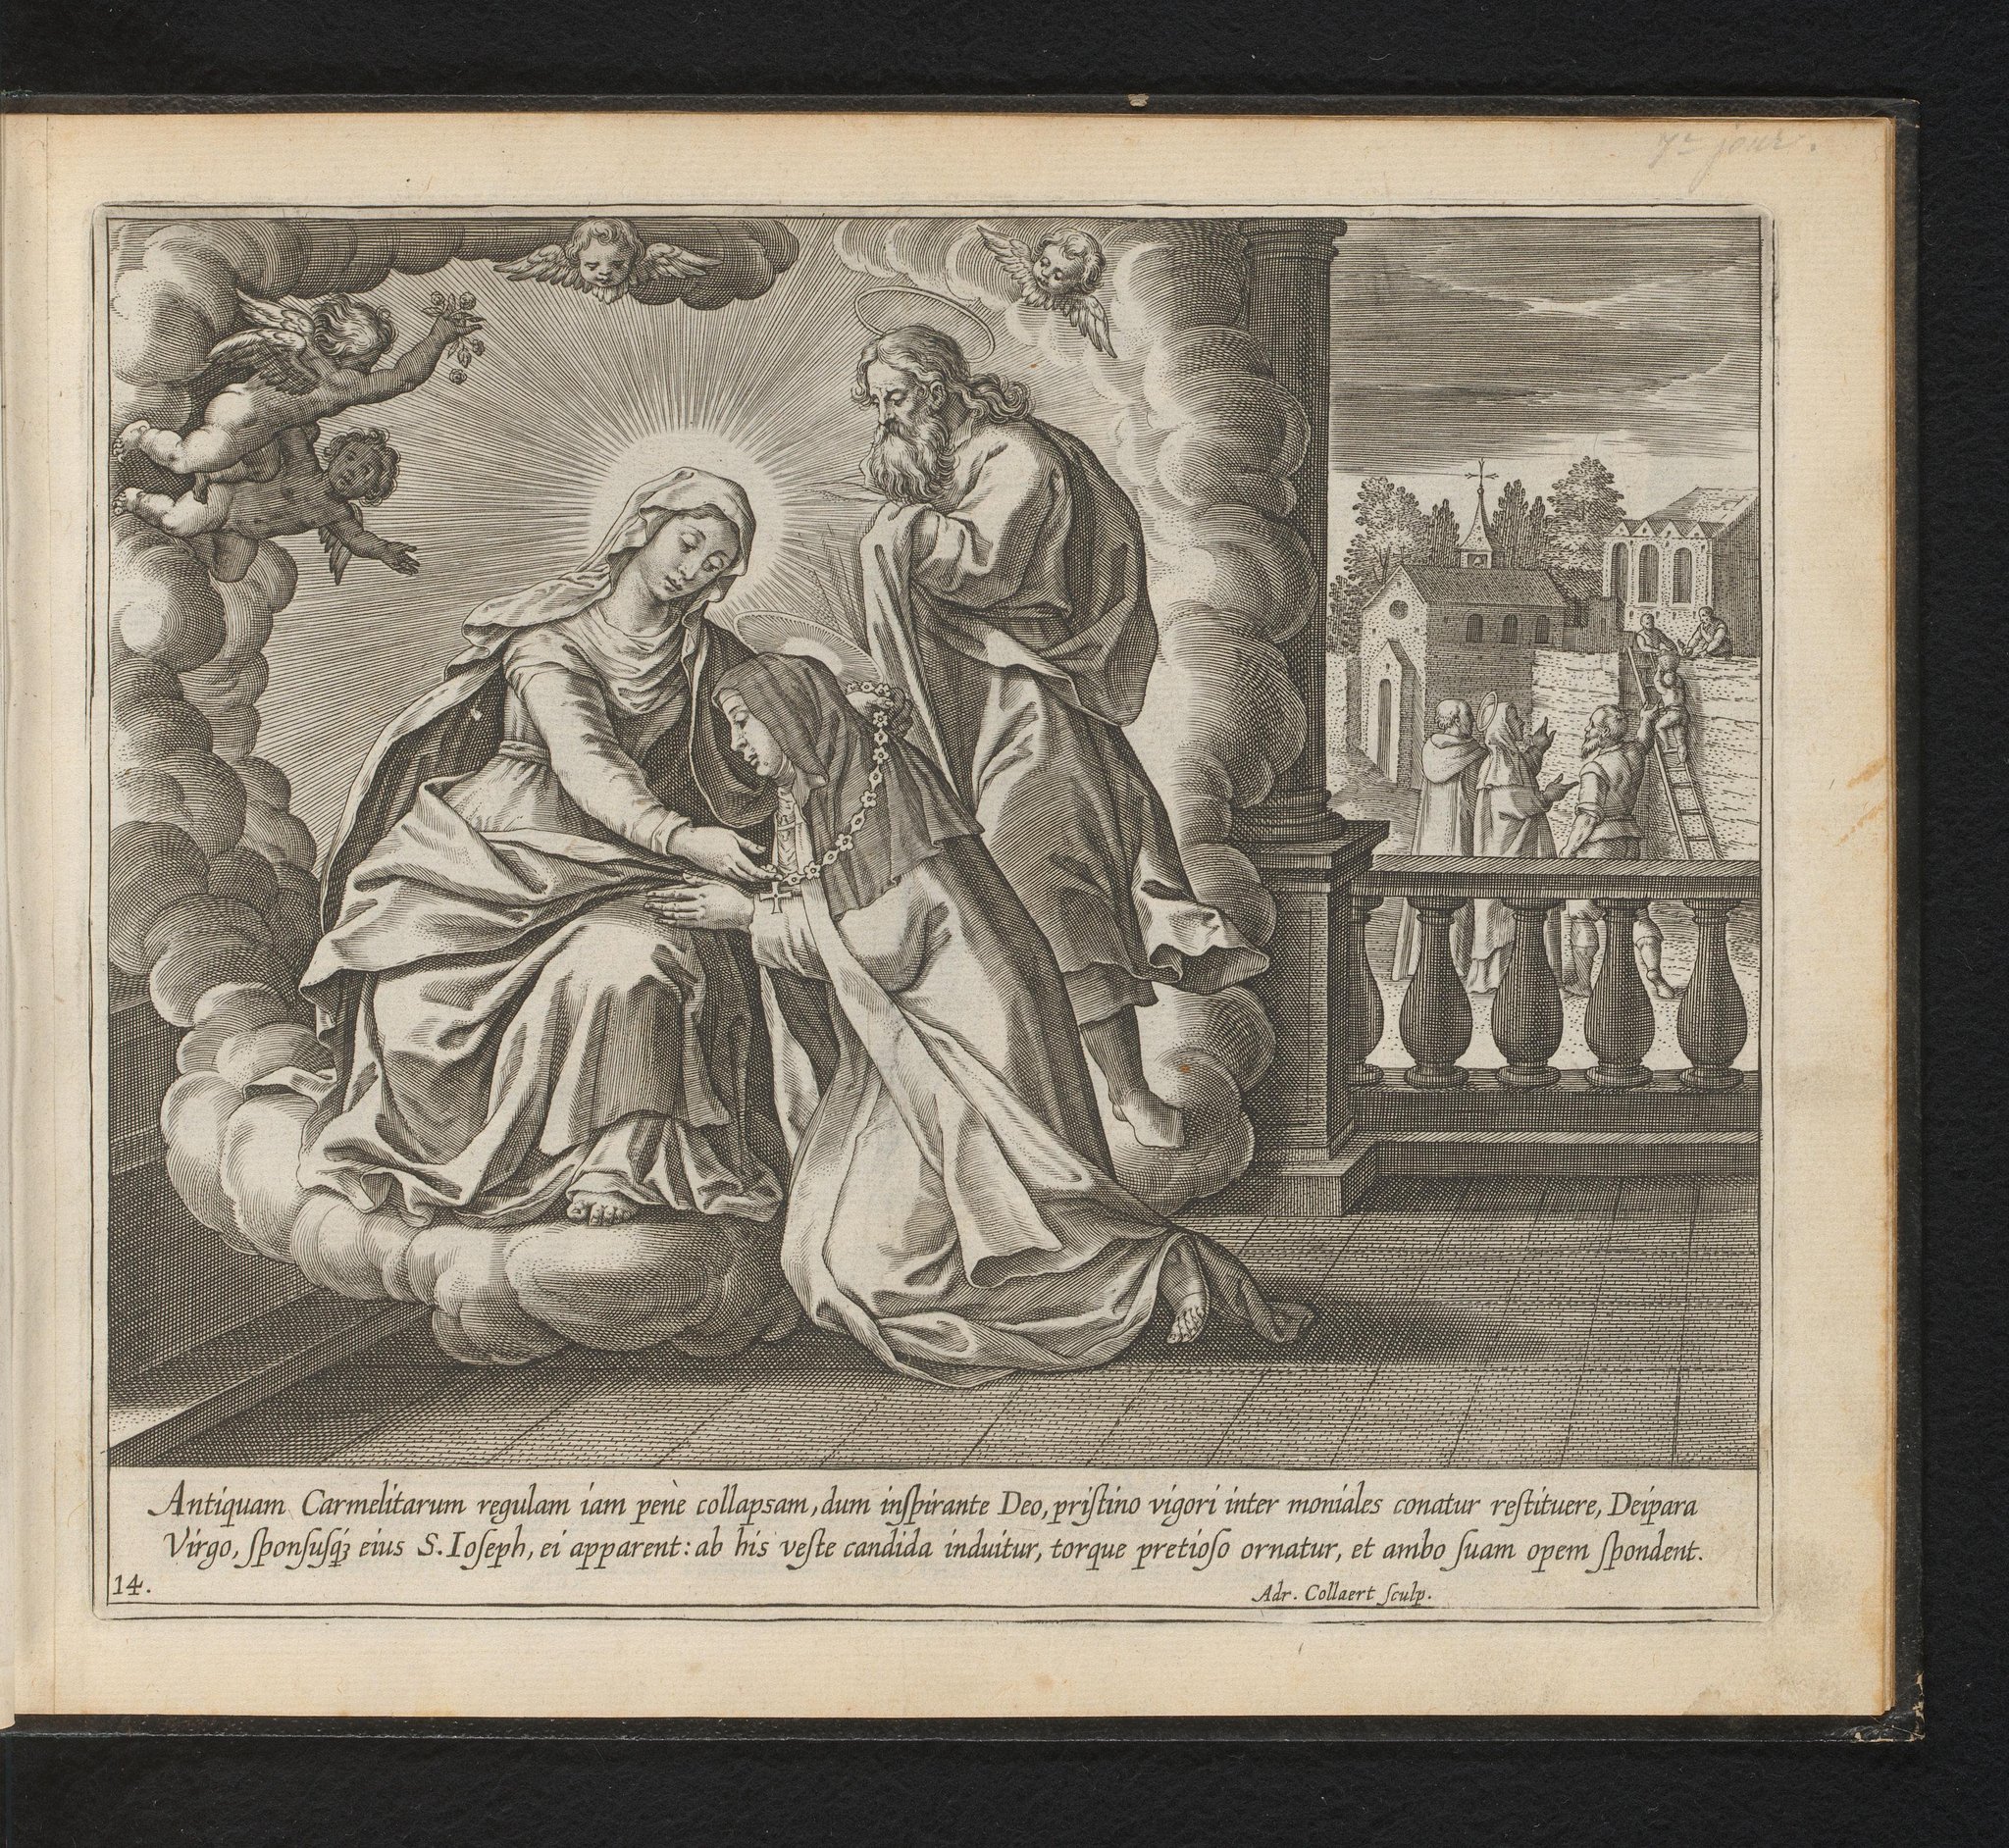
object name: print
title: De H. Maagd en de H. Jozef verschijnen aan Theresa en schenken haar een kostbare halsketting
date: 1613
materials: paper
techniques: engraving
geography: antwerp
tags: the virgin mary and joseph appear to st. theresa; the first gives her a necklace, the second a cloak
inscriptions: number: ‘14’, caption: ‘Antiquam Carmelitarum regulam...suam opem spondent.’, signature: ‘Adr. Collaert sculp.’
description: Prent in album 'Vita B. Virginis Teresiae A. Jesu ordinis carmelitarum excalceatorum piae restauratricis..., 1613.